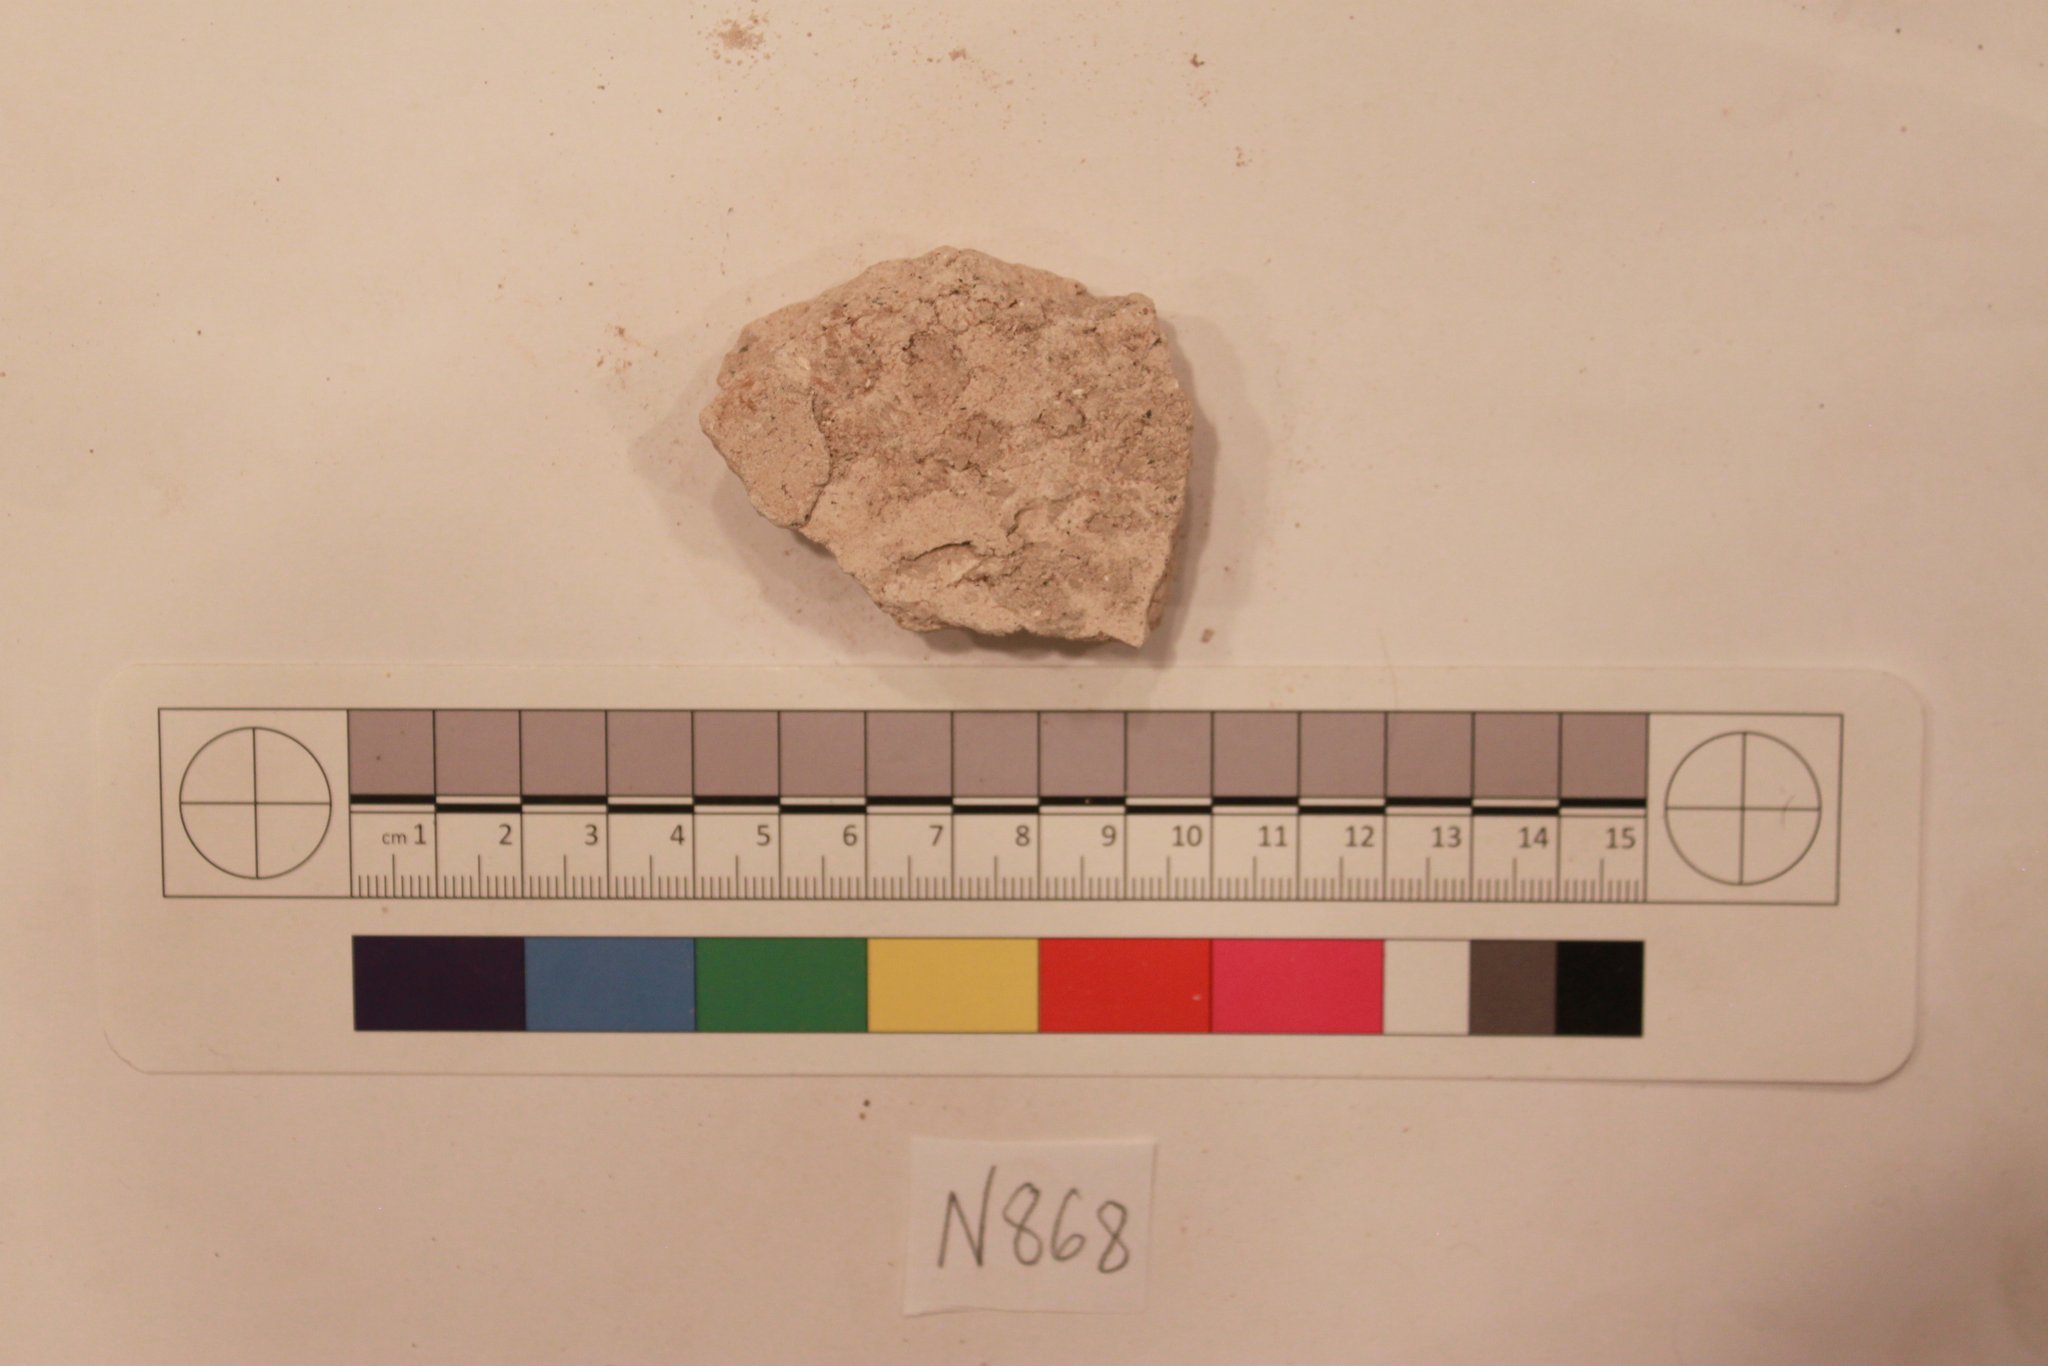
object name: fragment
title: Stucco Fragment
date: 701-1200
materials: plaster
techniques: carving, painting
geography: iran